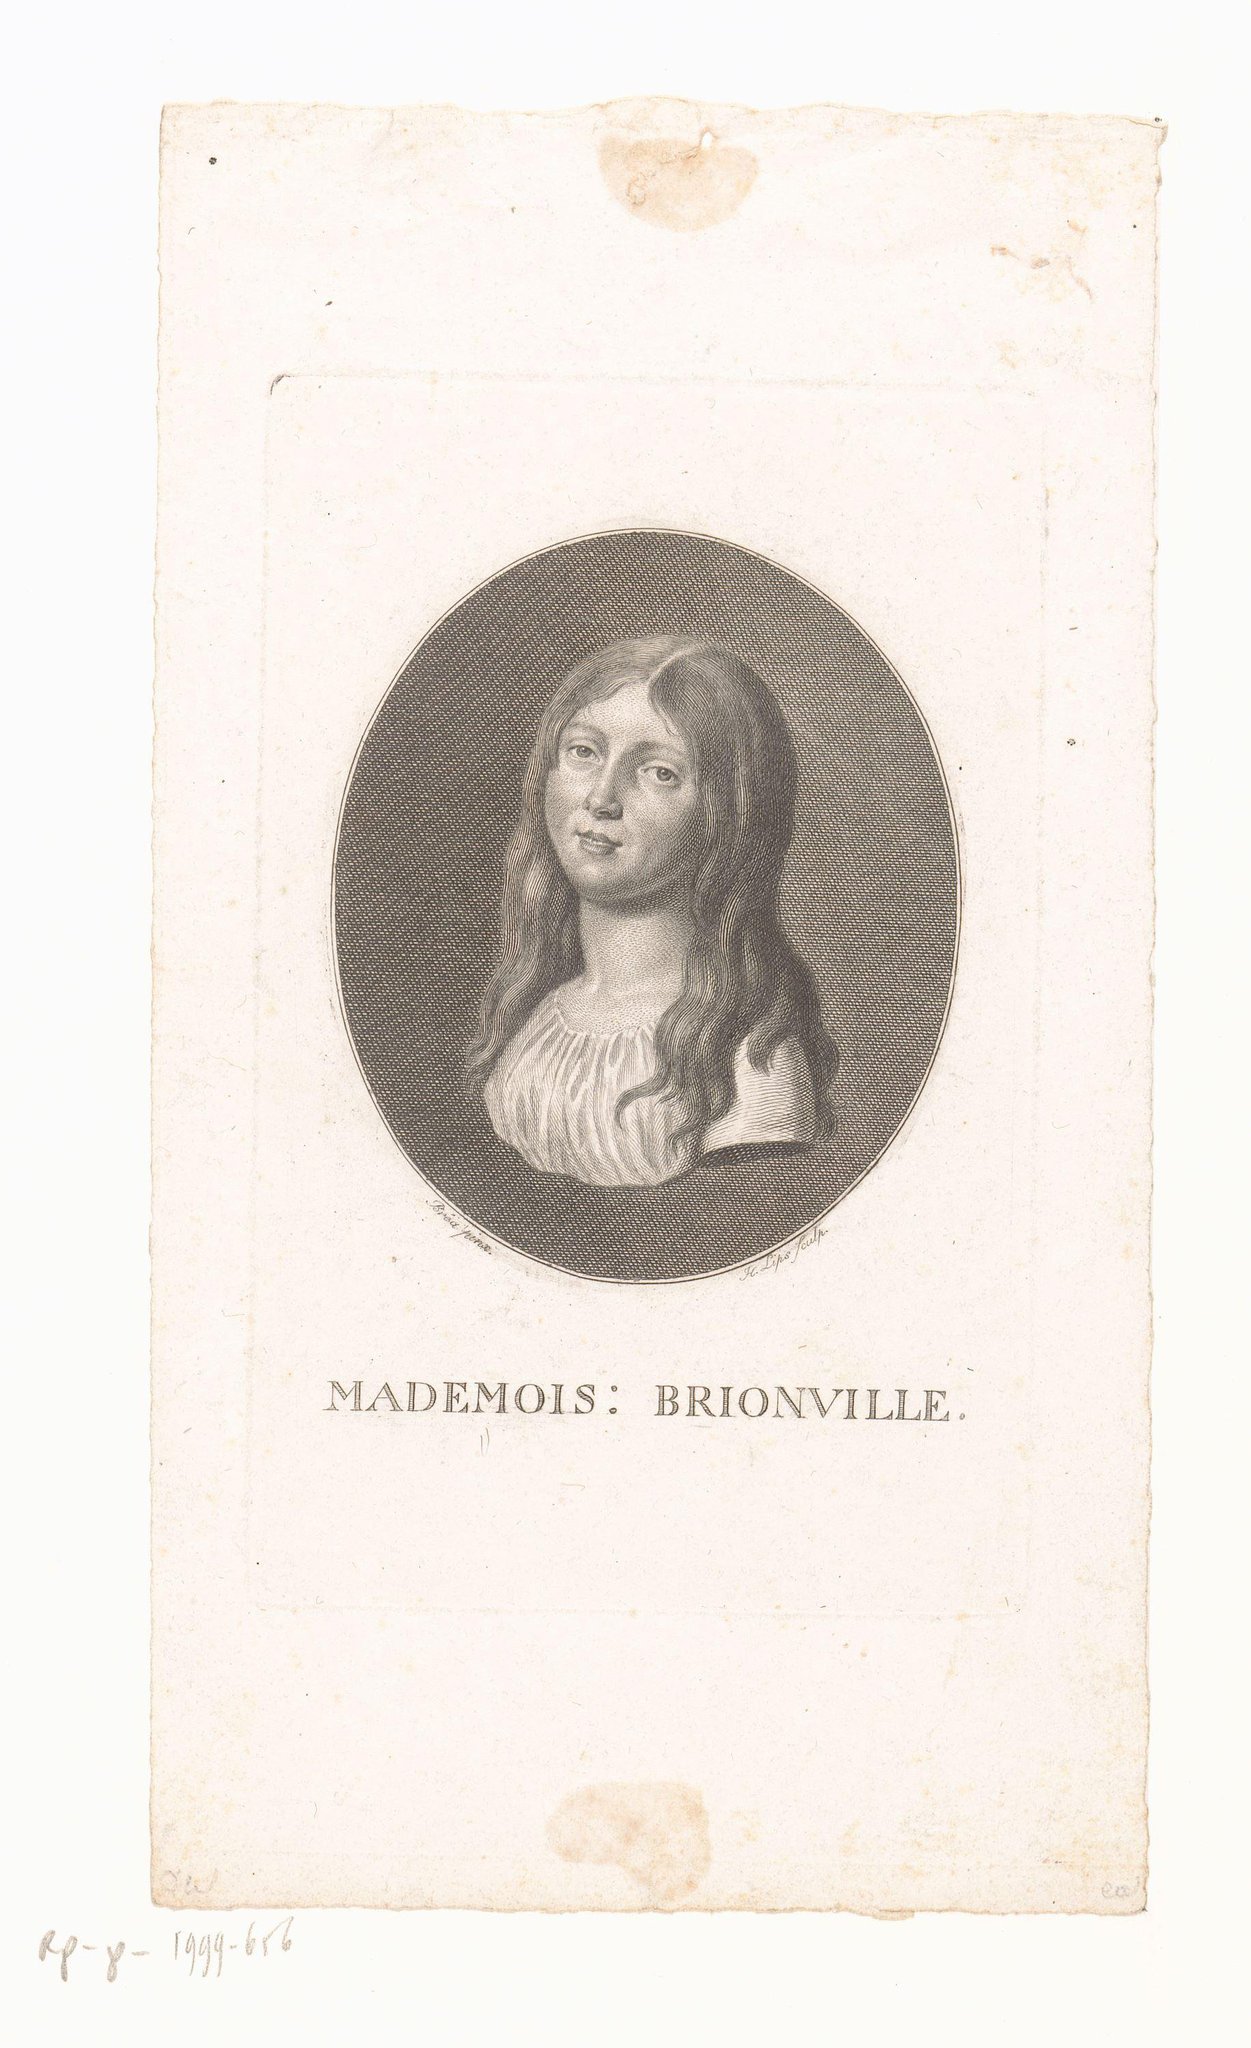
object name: print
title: Portret van Augustine Sophie de Blanqui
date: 1768-1817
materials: paper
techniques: engraving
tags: historical persons - bb - woman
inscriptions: collector's mark: Lugt 2228, collector's mark: Lugt 2760